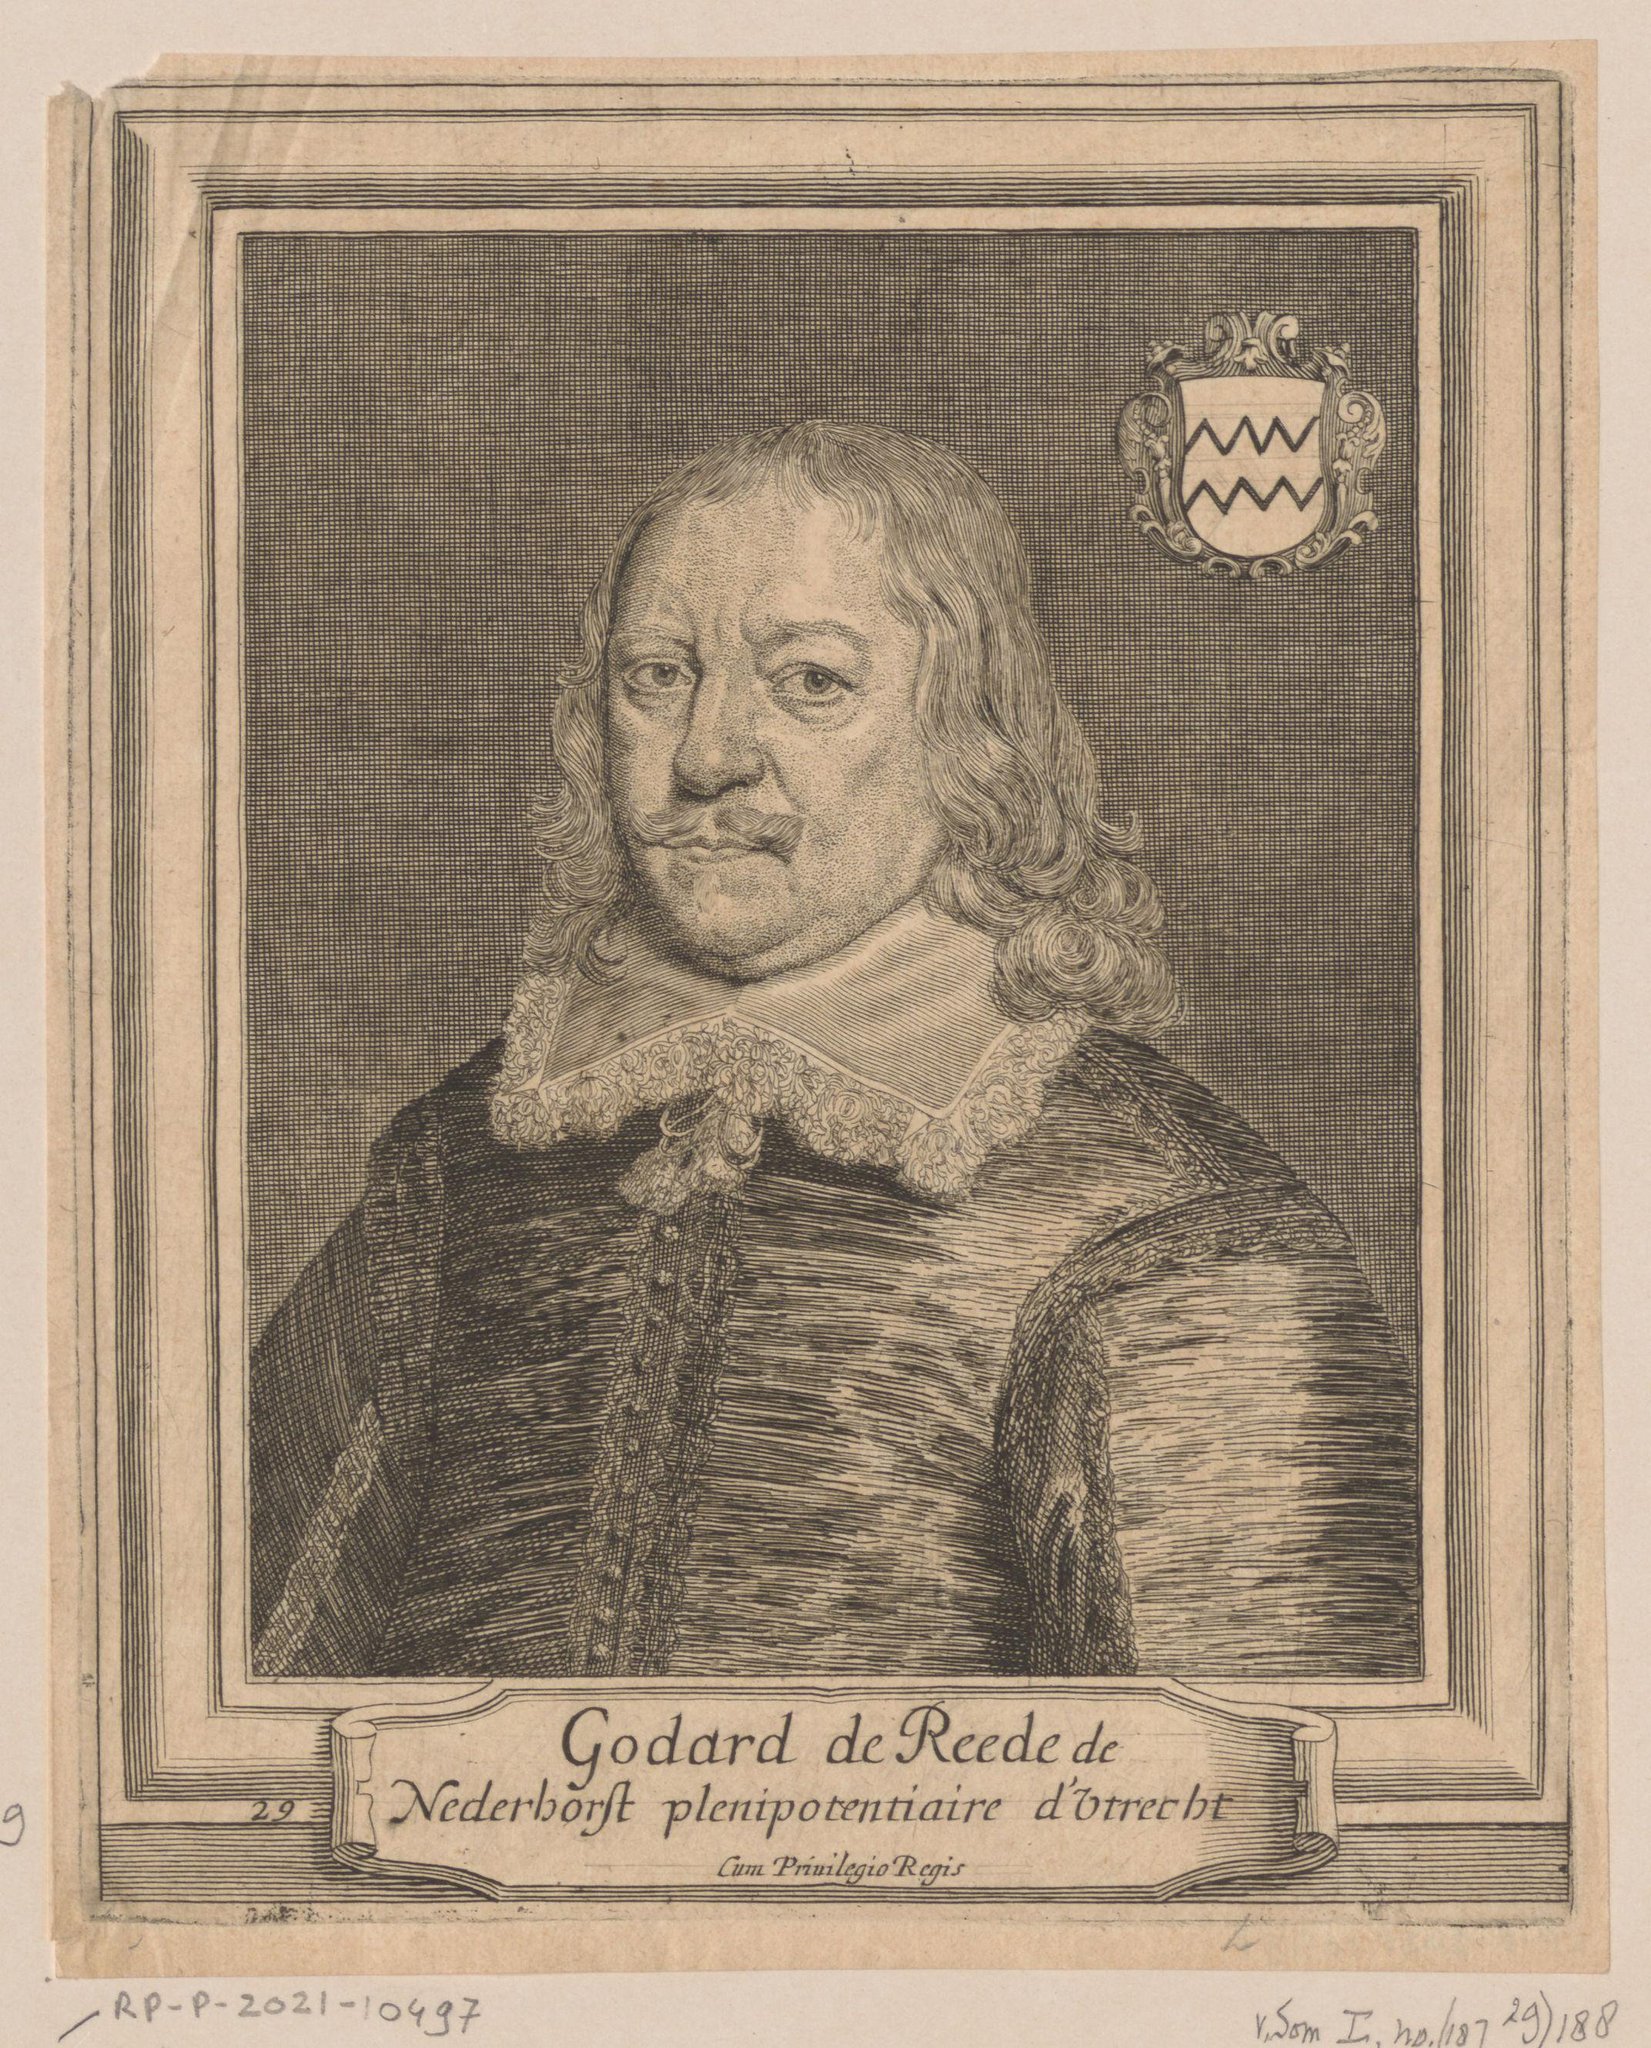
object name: print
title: Portretten van onderhandelaars bij de Vrede van Munster en Osnabrück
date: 1648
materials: paper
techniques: engraving, etching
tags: historical persons, negotiations, conference ~ diplomacy, armorial bearing, heraldry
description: Prent waarschijnlijk uit: Legatorum omnium Tam Monasterij, quam Osnabrugae (...). Parijs: s.n., 1648. Of uit: Bignon, François. Les portraictz au naturel avec les armoiries et blasons noms et qualitez de Messieurs les plénipotentiaires assemblez à Munster et Osnaburg (...). Parijs: Henry Sara en Jean Paslé, [1648].